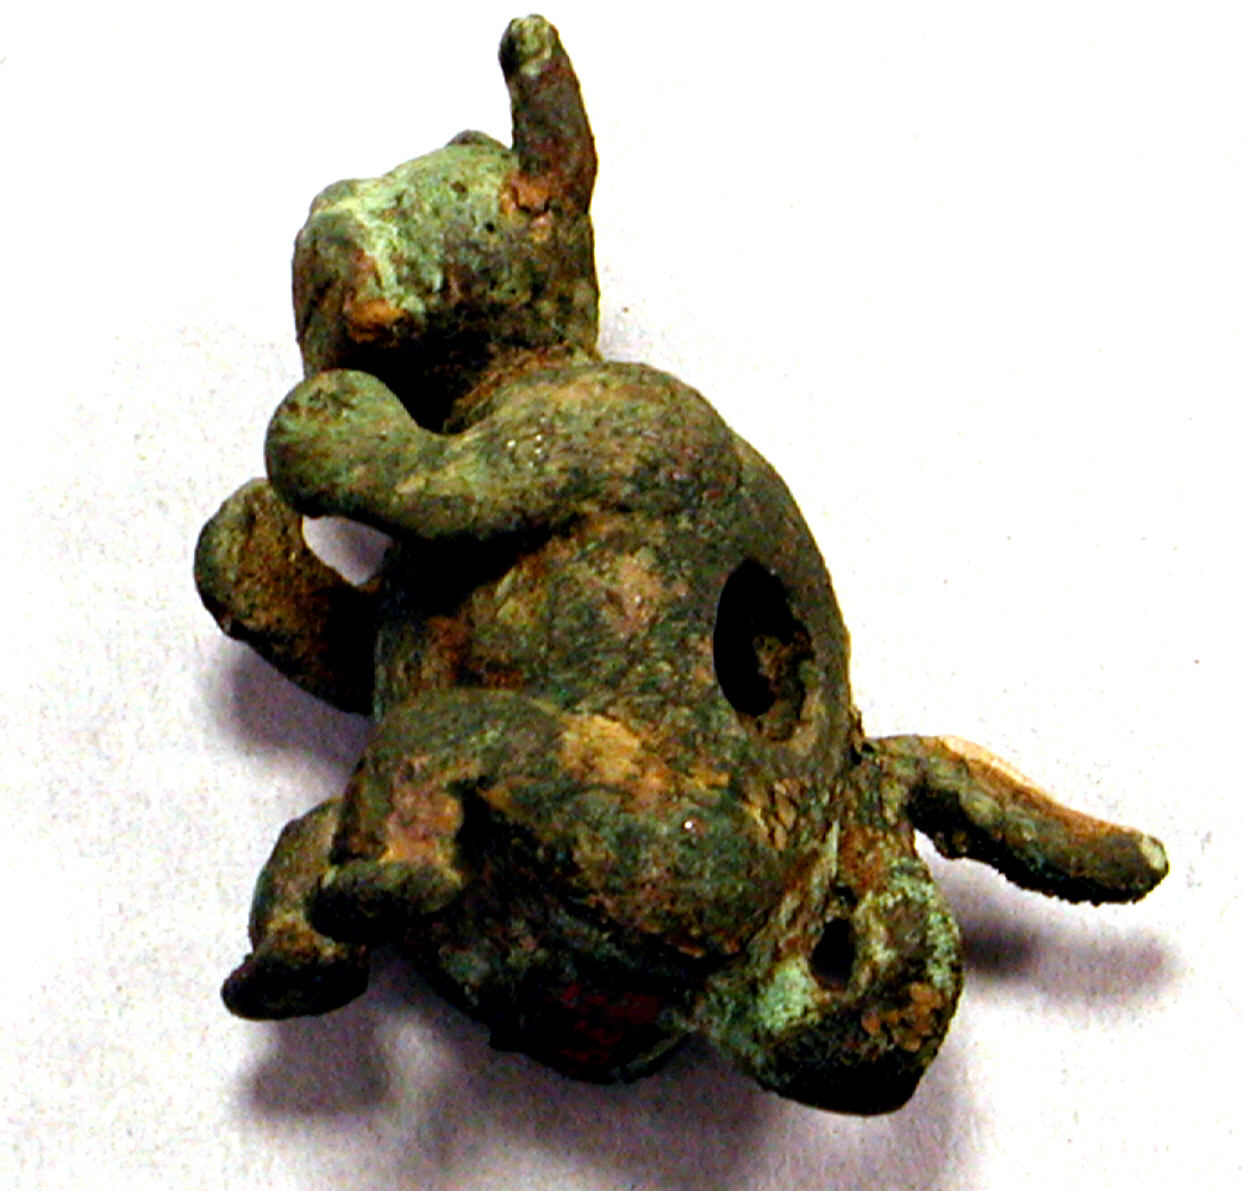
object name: ornament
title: Copper Animal Ornament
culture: peruvian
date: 1501-1600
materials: copper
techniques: casting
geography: peru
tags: animals